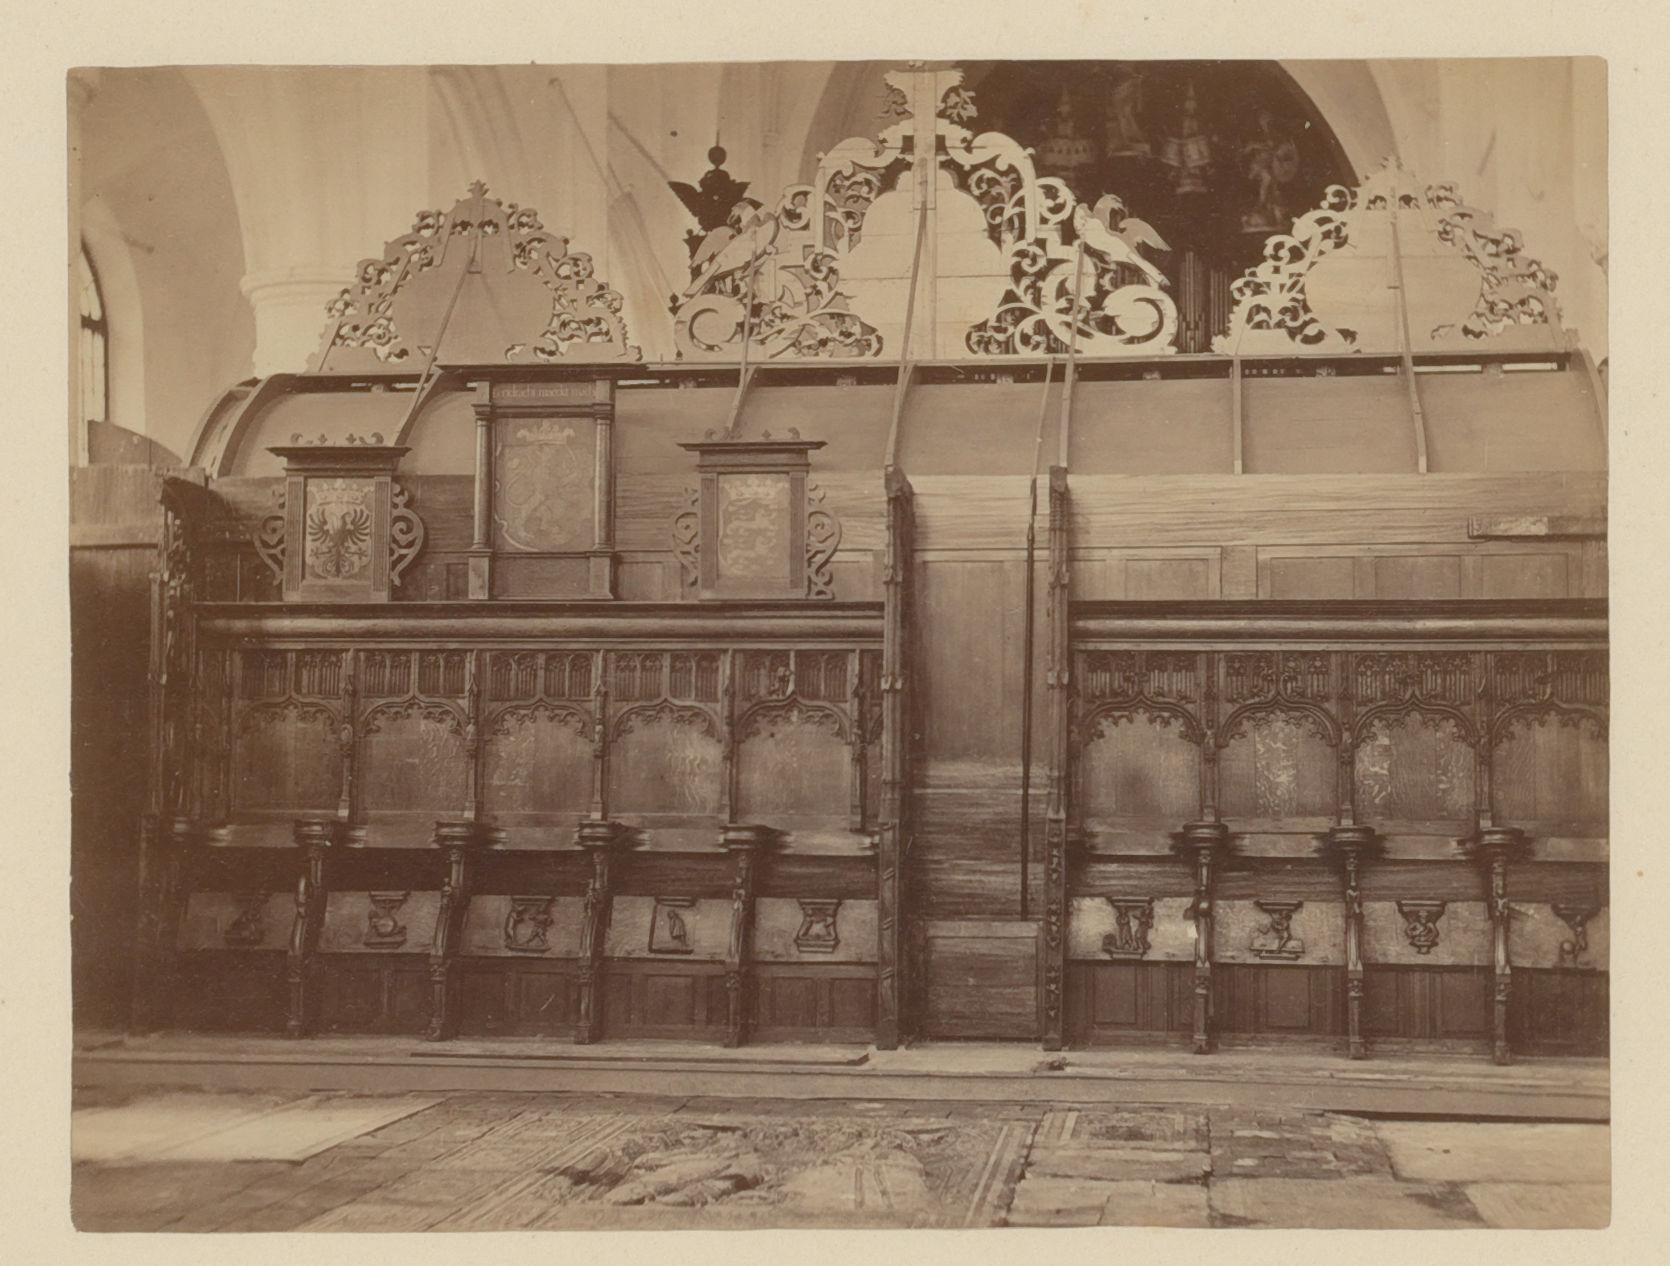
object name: photograph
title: Houtsnijwerk op de koorbanken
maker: g.m. märckelbach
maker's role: publisher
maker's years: 1853-1904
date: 1879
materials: photographic support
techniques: albumen print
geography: bolsward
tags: carving ~ applied arts, piece of sculpture, reproduction of a piece of sculpture, wood carver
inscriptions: collector's mark, collector's mark: Lugt 1641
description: In een advertentie wordt de fotoserie aangeboden: HH. Liefhebbers van Antiquiteiten. GOTHIEKE BANKEN uit de XVe Eeuw. St. MARTINIKERK.--BOLSWARD. 8 Photographieën à f 4.50. ANTIEKE PREEKSTOEL, uit het midden der XVIIe EEUW. 4 Photographieën à f 2.25. Uitgave van: GEBRs. CORDES, Photografen [and] G.M. MÄRCKELBACH, Boek- en Kunsthandel, BOLSWARD. (Het nieuws van den dag: kleine courant, 12-07-1879.)